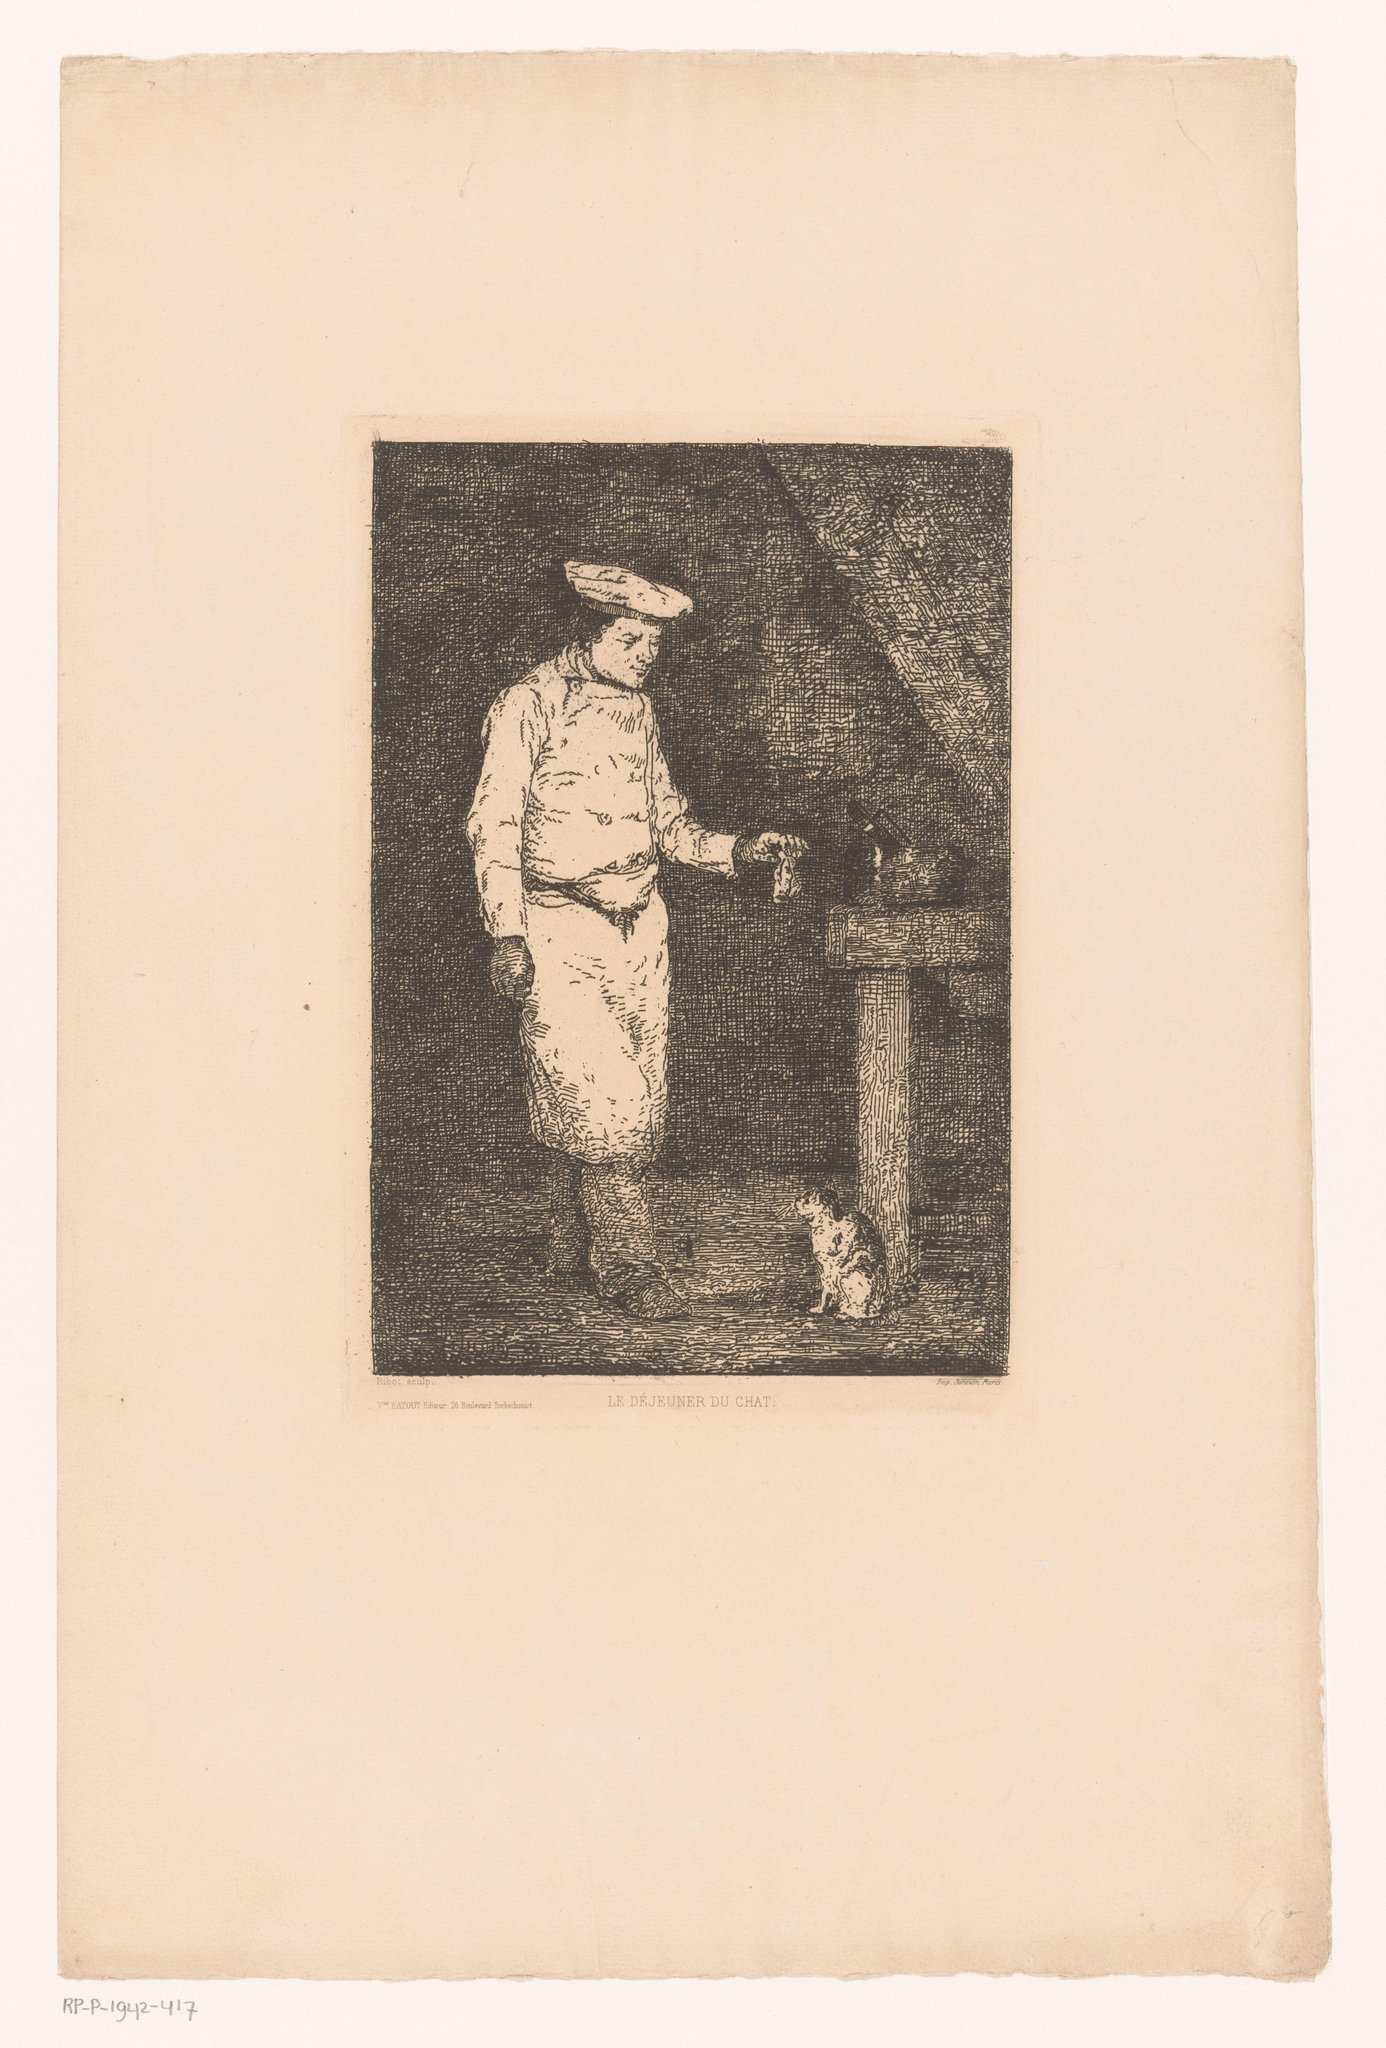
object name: print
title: Eaux-Fortes Modernes: Originales et Inédites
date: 1867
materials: paper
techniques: etching, intaglio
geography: paris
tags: cat, cook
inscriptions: collector's mark: Lugt 2760, collector's mark: Lugt 2228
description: Maakt deel uit van het eerste volume van een serie prenten door de Société des Aquafortistes uit 1867. Plaat 289.